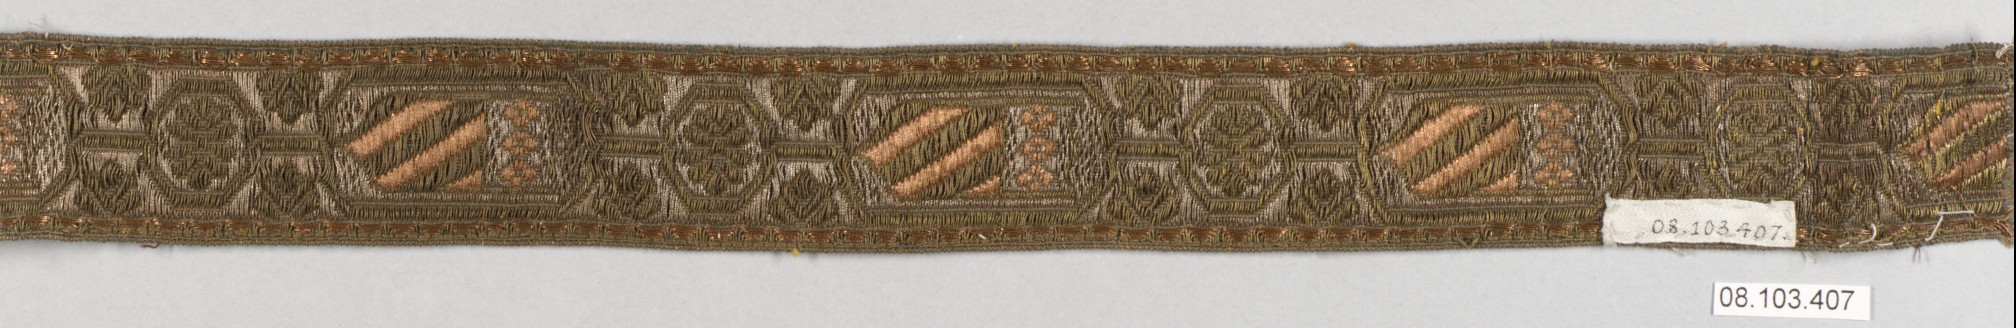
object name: galloon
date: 1701-1900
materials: metal thread